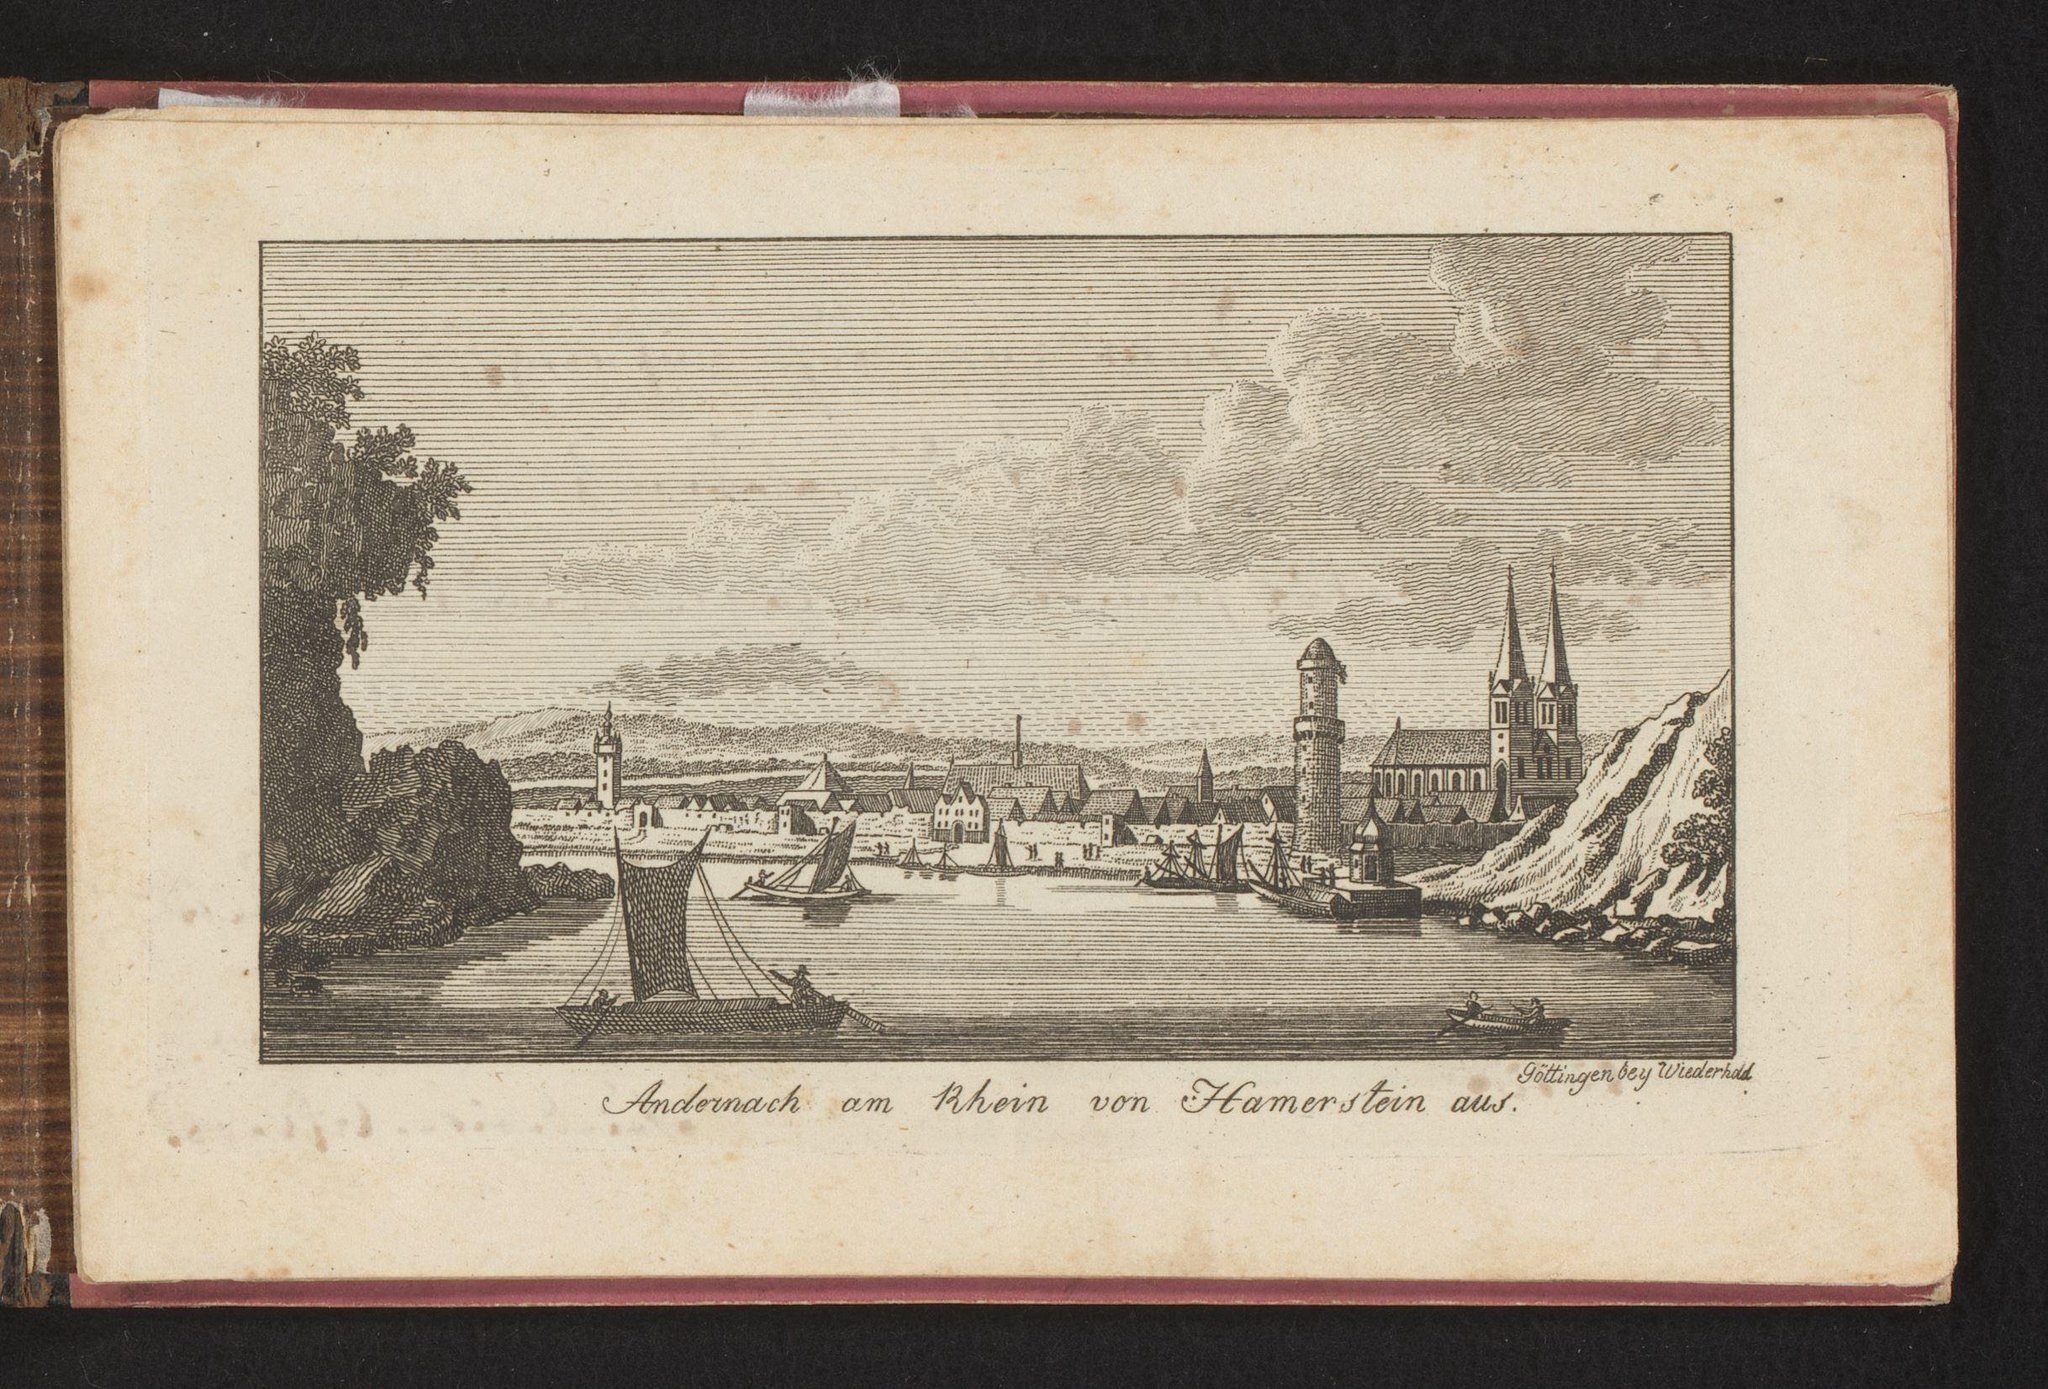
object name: print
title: Andernach am Rein von Hamerstein aus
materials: ink, paper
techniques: etching, writing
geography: gottingen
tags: 'album amicorum', 'stammbuch', river (+ landscape with figures, staffage), city-view in general; 'veduta' (+ city(-scape) with figures, staffage)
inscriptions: tekst, verso, handgeschreven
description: Handgeschreven tekst in het Duits op het verso.